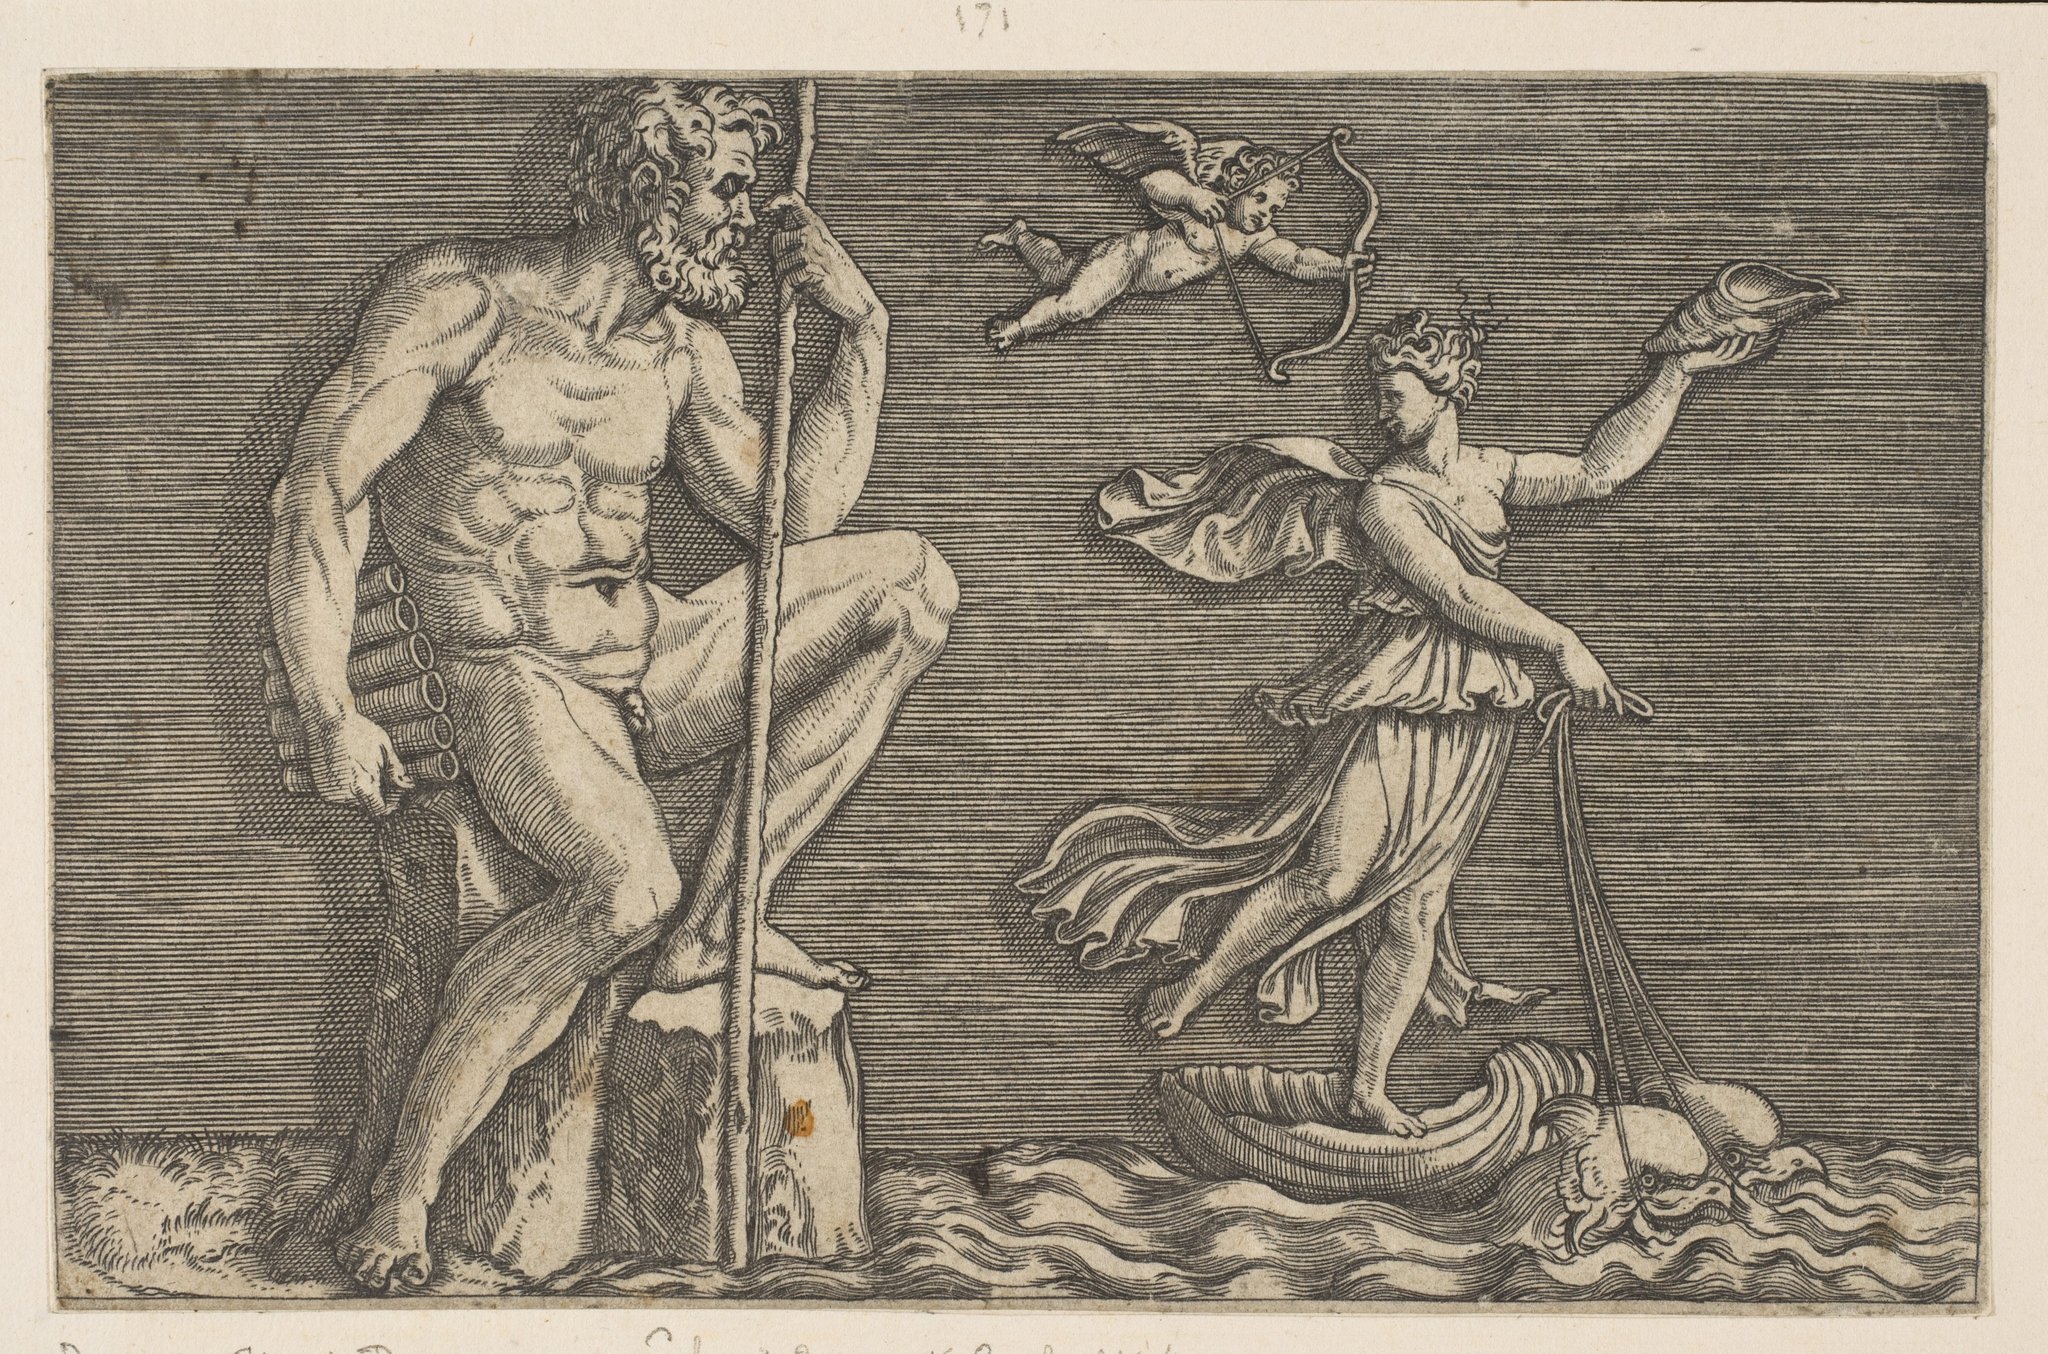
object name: print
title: Galatea escaping Polyphemus; he is seated on a rock holding a staff and pipes and looking towards Galatea at right riding a shell pulled by two dolphins, Cupid flying above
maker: marco dente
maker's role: artist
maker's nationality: italian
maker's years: 1515-1527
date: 1515-1527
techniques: engraving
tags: male nudes,cupid,galatea